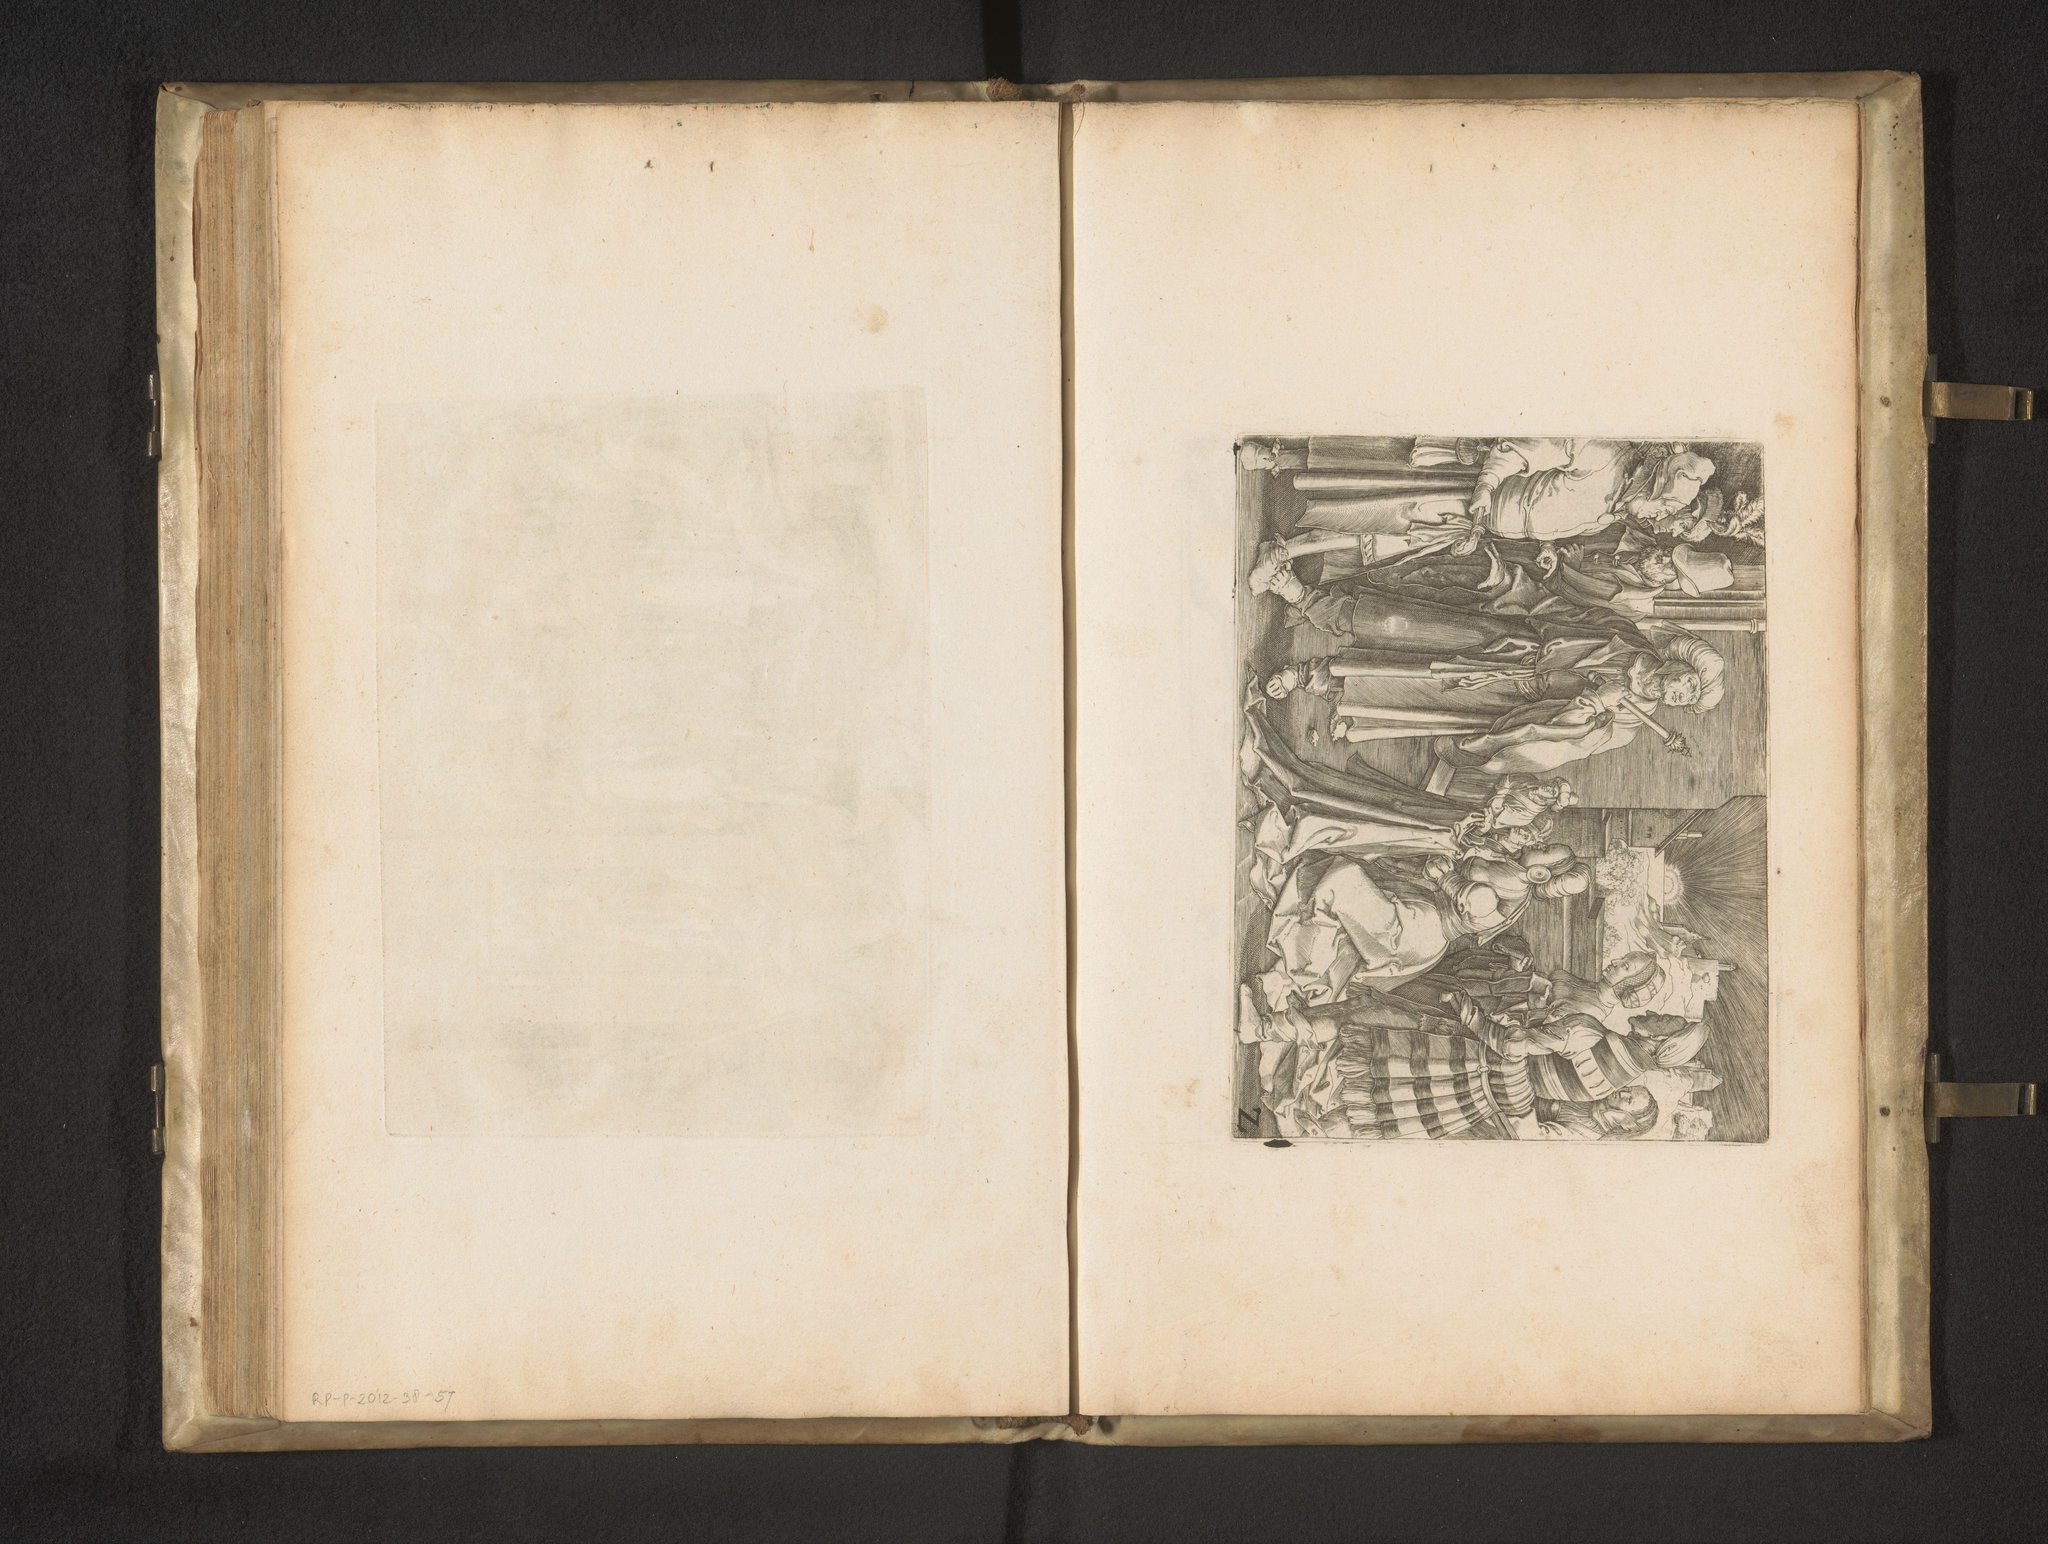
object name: print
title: Geschiedenis van Jozef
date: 1581-1628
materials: paper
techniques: engraving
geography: amsterdam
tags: potiphar's wife before her husband: she accuses joseph of trying to violate her, using the cloak as evidence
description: Vrouw van Potifar, geknield, toont mantel van Jozef aan Potifar. Onderdeel van een serie van vijf prenten van de geschiedenis van Jozef. Met de hand genummerd rechtsonder: 2. Onderdeel van een album met voornamelijk christelijke voorstellingen.